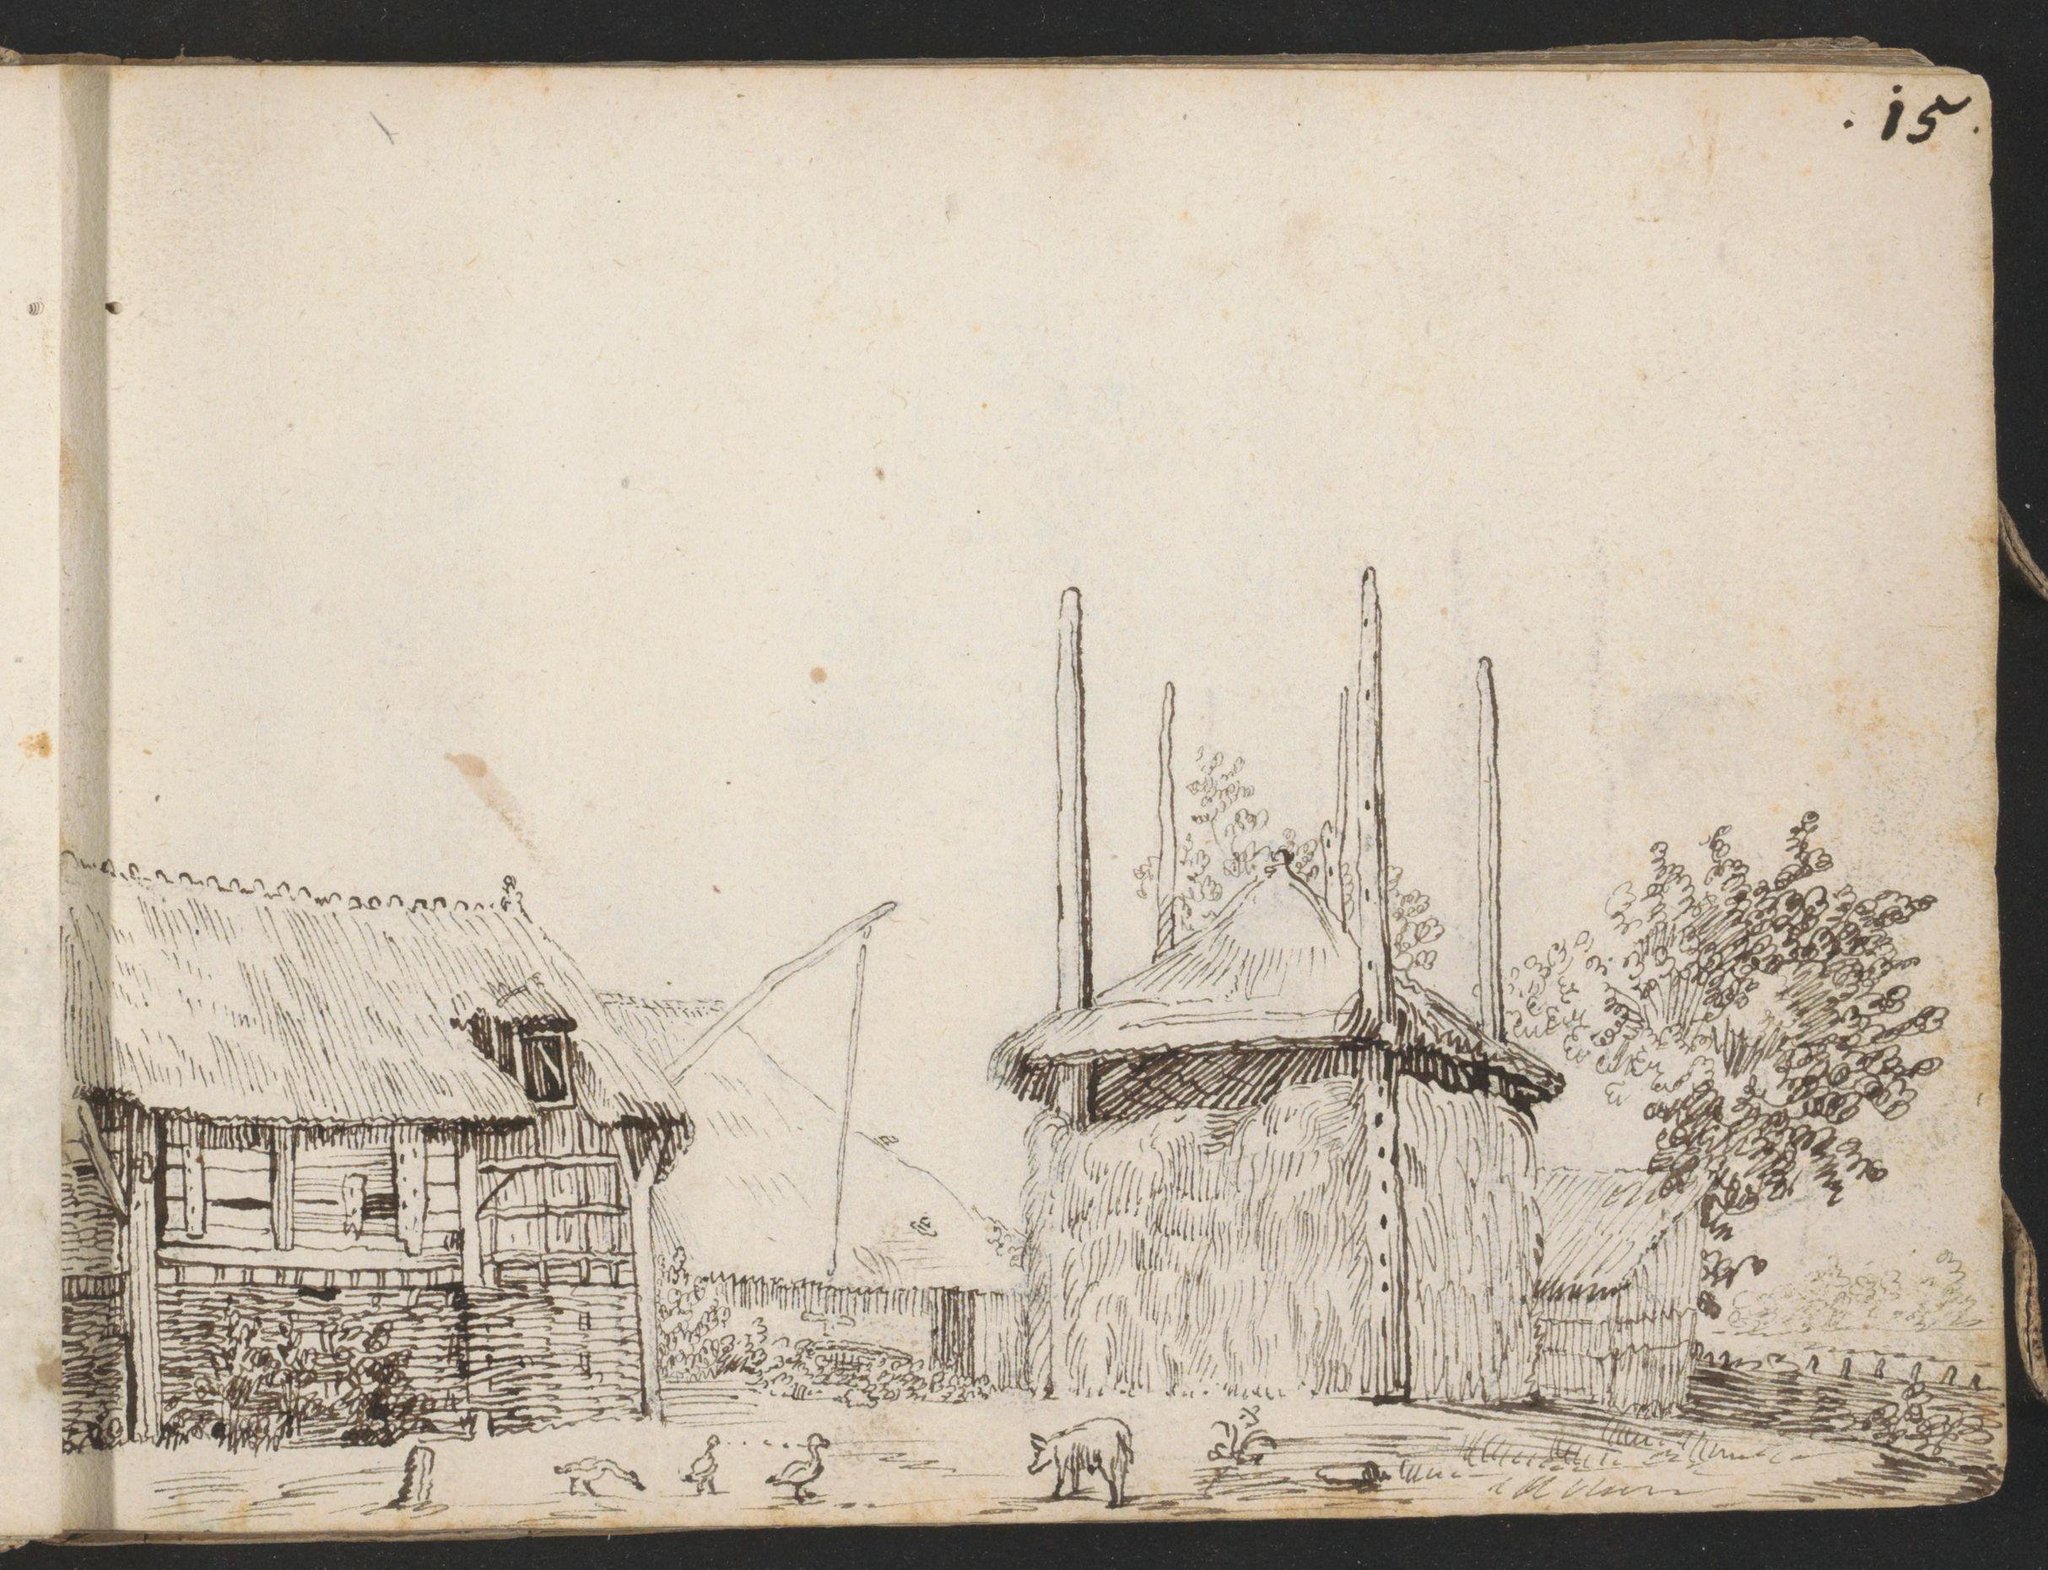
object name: sketchbook leaf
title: Boerenerf met een waterput, hooischuur en scharrelende dieren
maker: gerard ter borch (ii)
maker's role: draughtsman, painter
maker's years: 1617-1681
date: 1631-1633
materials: ink, paper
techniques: pen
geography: zwolle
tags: courtyard, hay-stack, farm (building)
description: Blad 15 recto uit een schetsboek met 55 bladen.